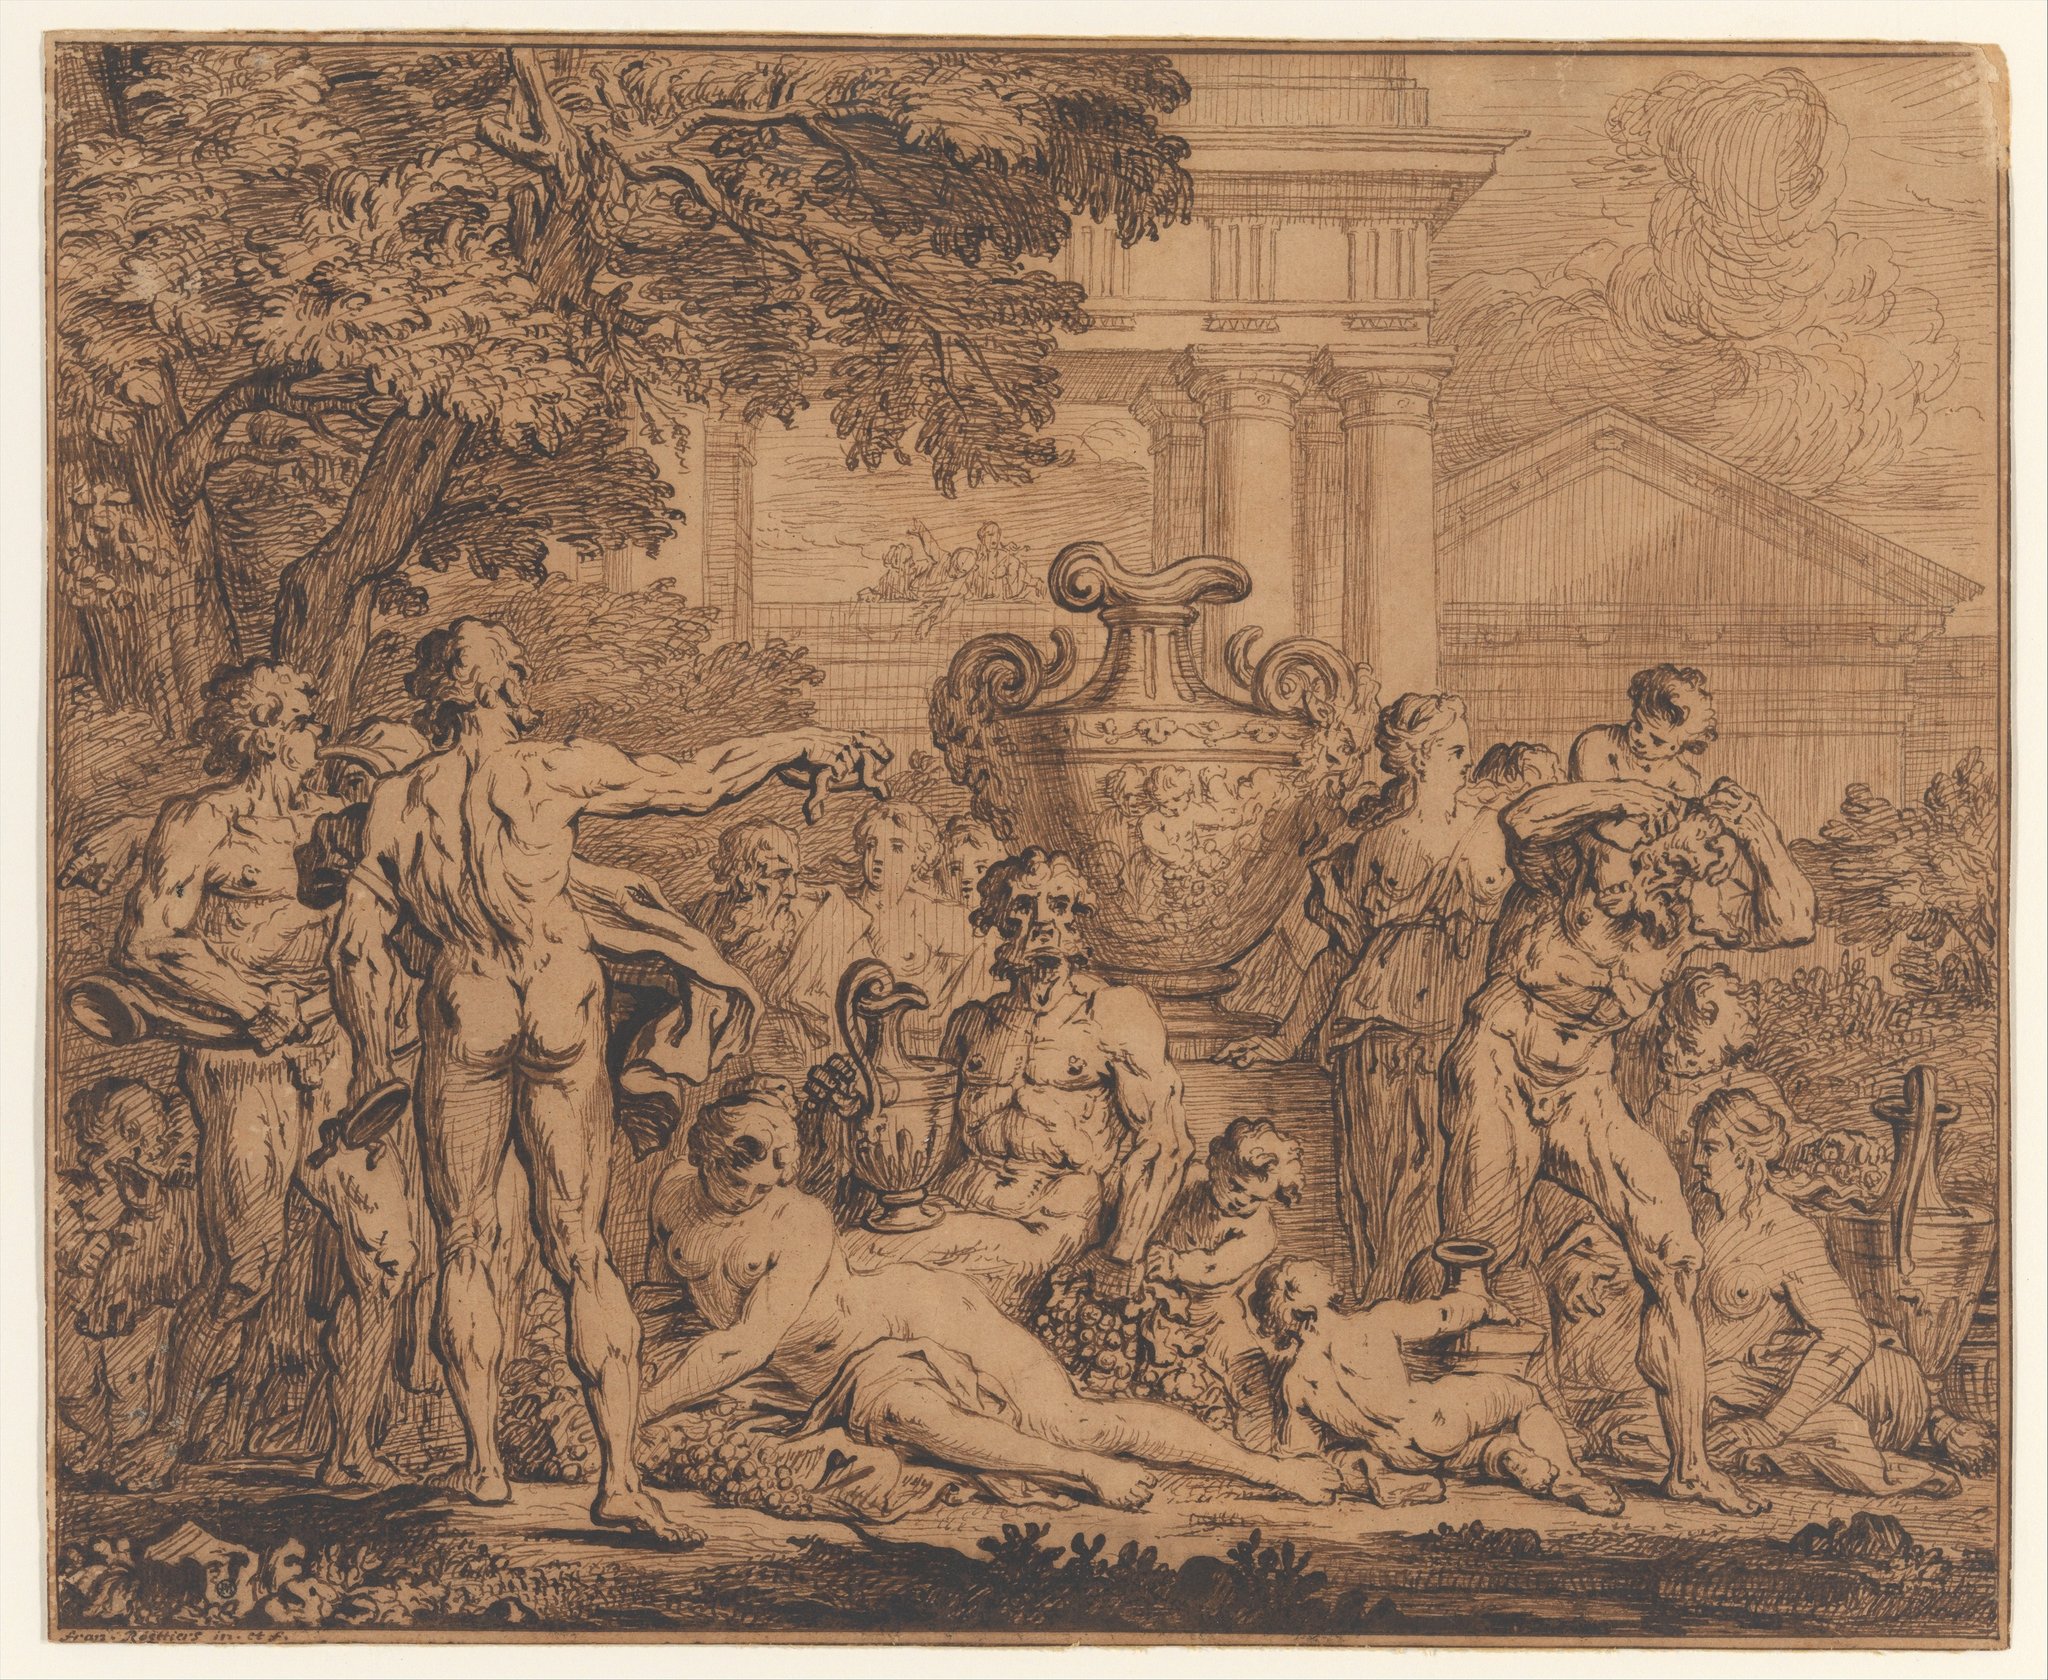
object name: drawing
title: Bacchanal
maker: françois roëttiers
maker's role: artist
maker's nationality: french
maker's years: 1685-1742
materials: ink, paper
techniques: brush, pen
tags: male nudes,female nudes